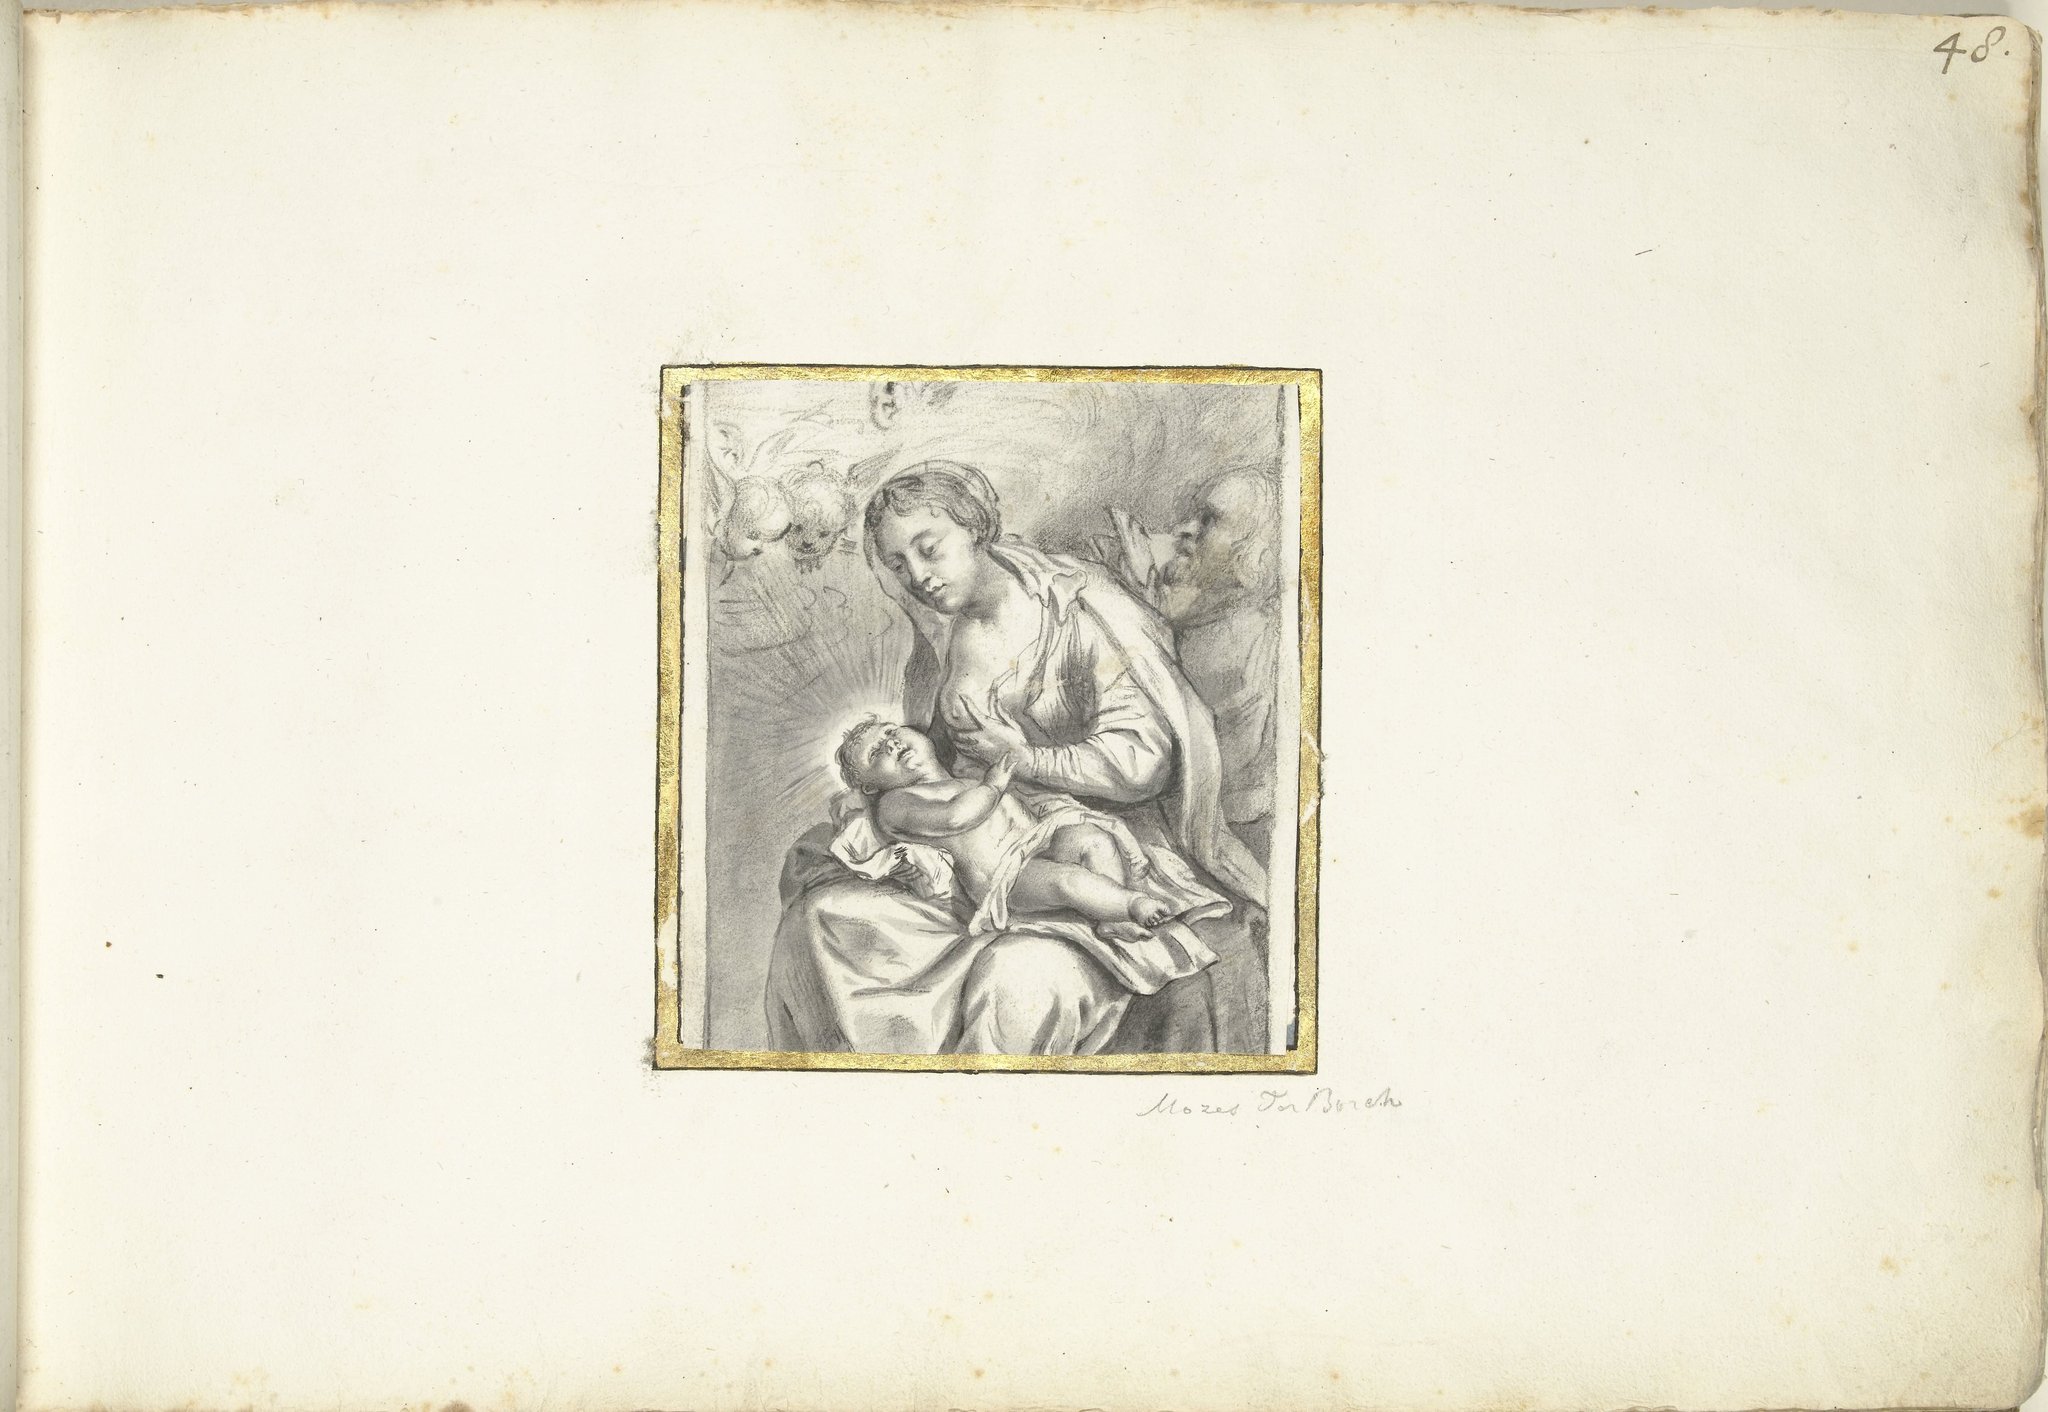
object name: drawing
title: De Heilige Familie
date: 1655-1667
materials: chalk, ink, paper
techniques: brush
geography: zwolle